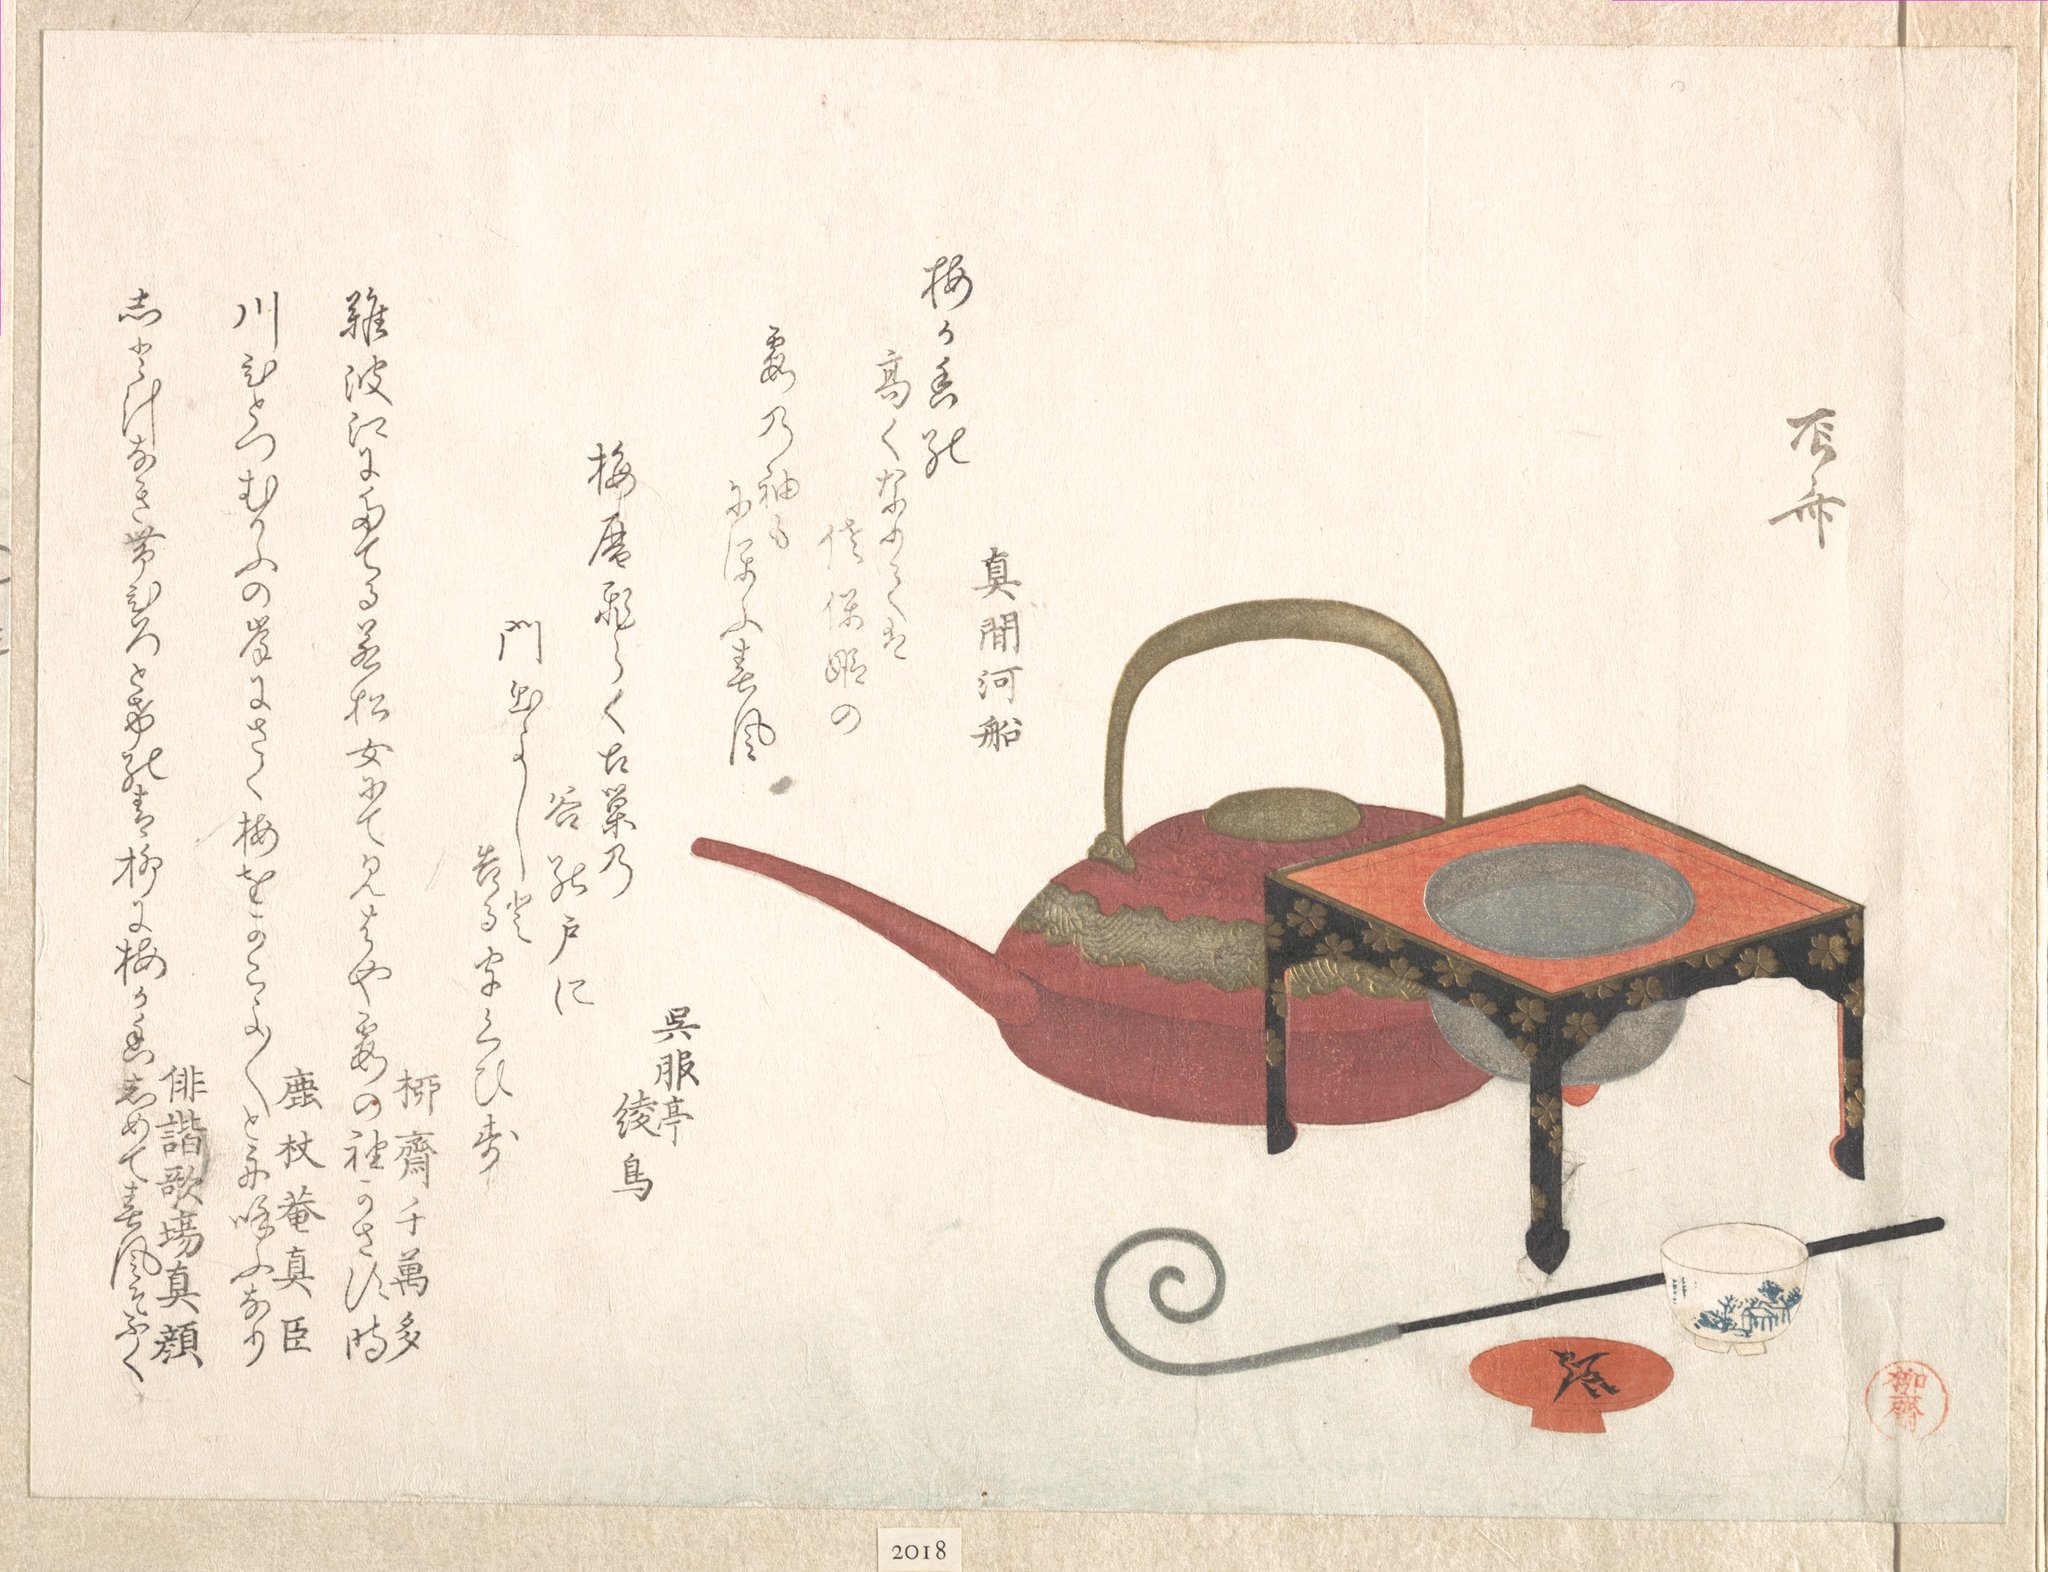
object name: print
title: Wine-Set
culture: japanese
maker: ryūryūkyo shinsai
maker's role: artist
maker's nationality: japanese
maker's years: 1799-1823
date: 1801-1900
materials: ink, paper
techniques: surimono, woodblock print